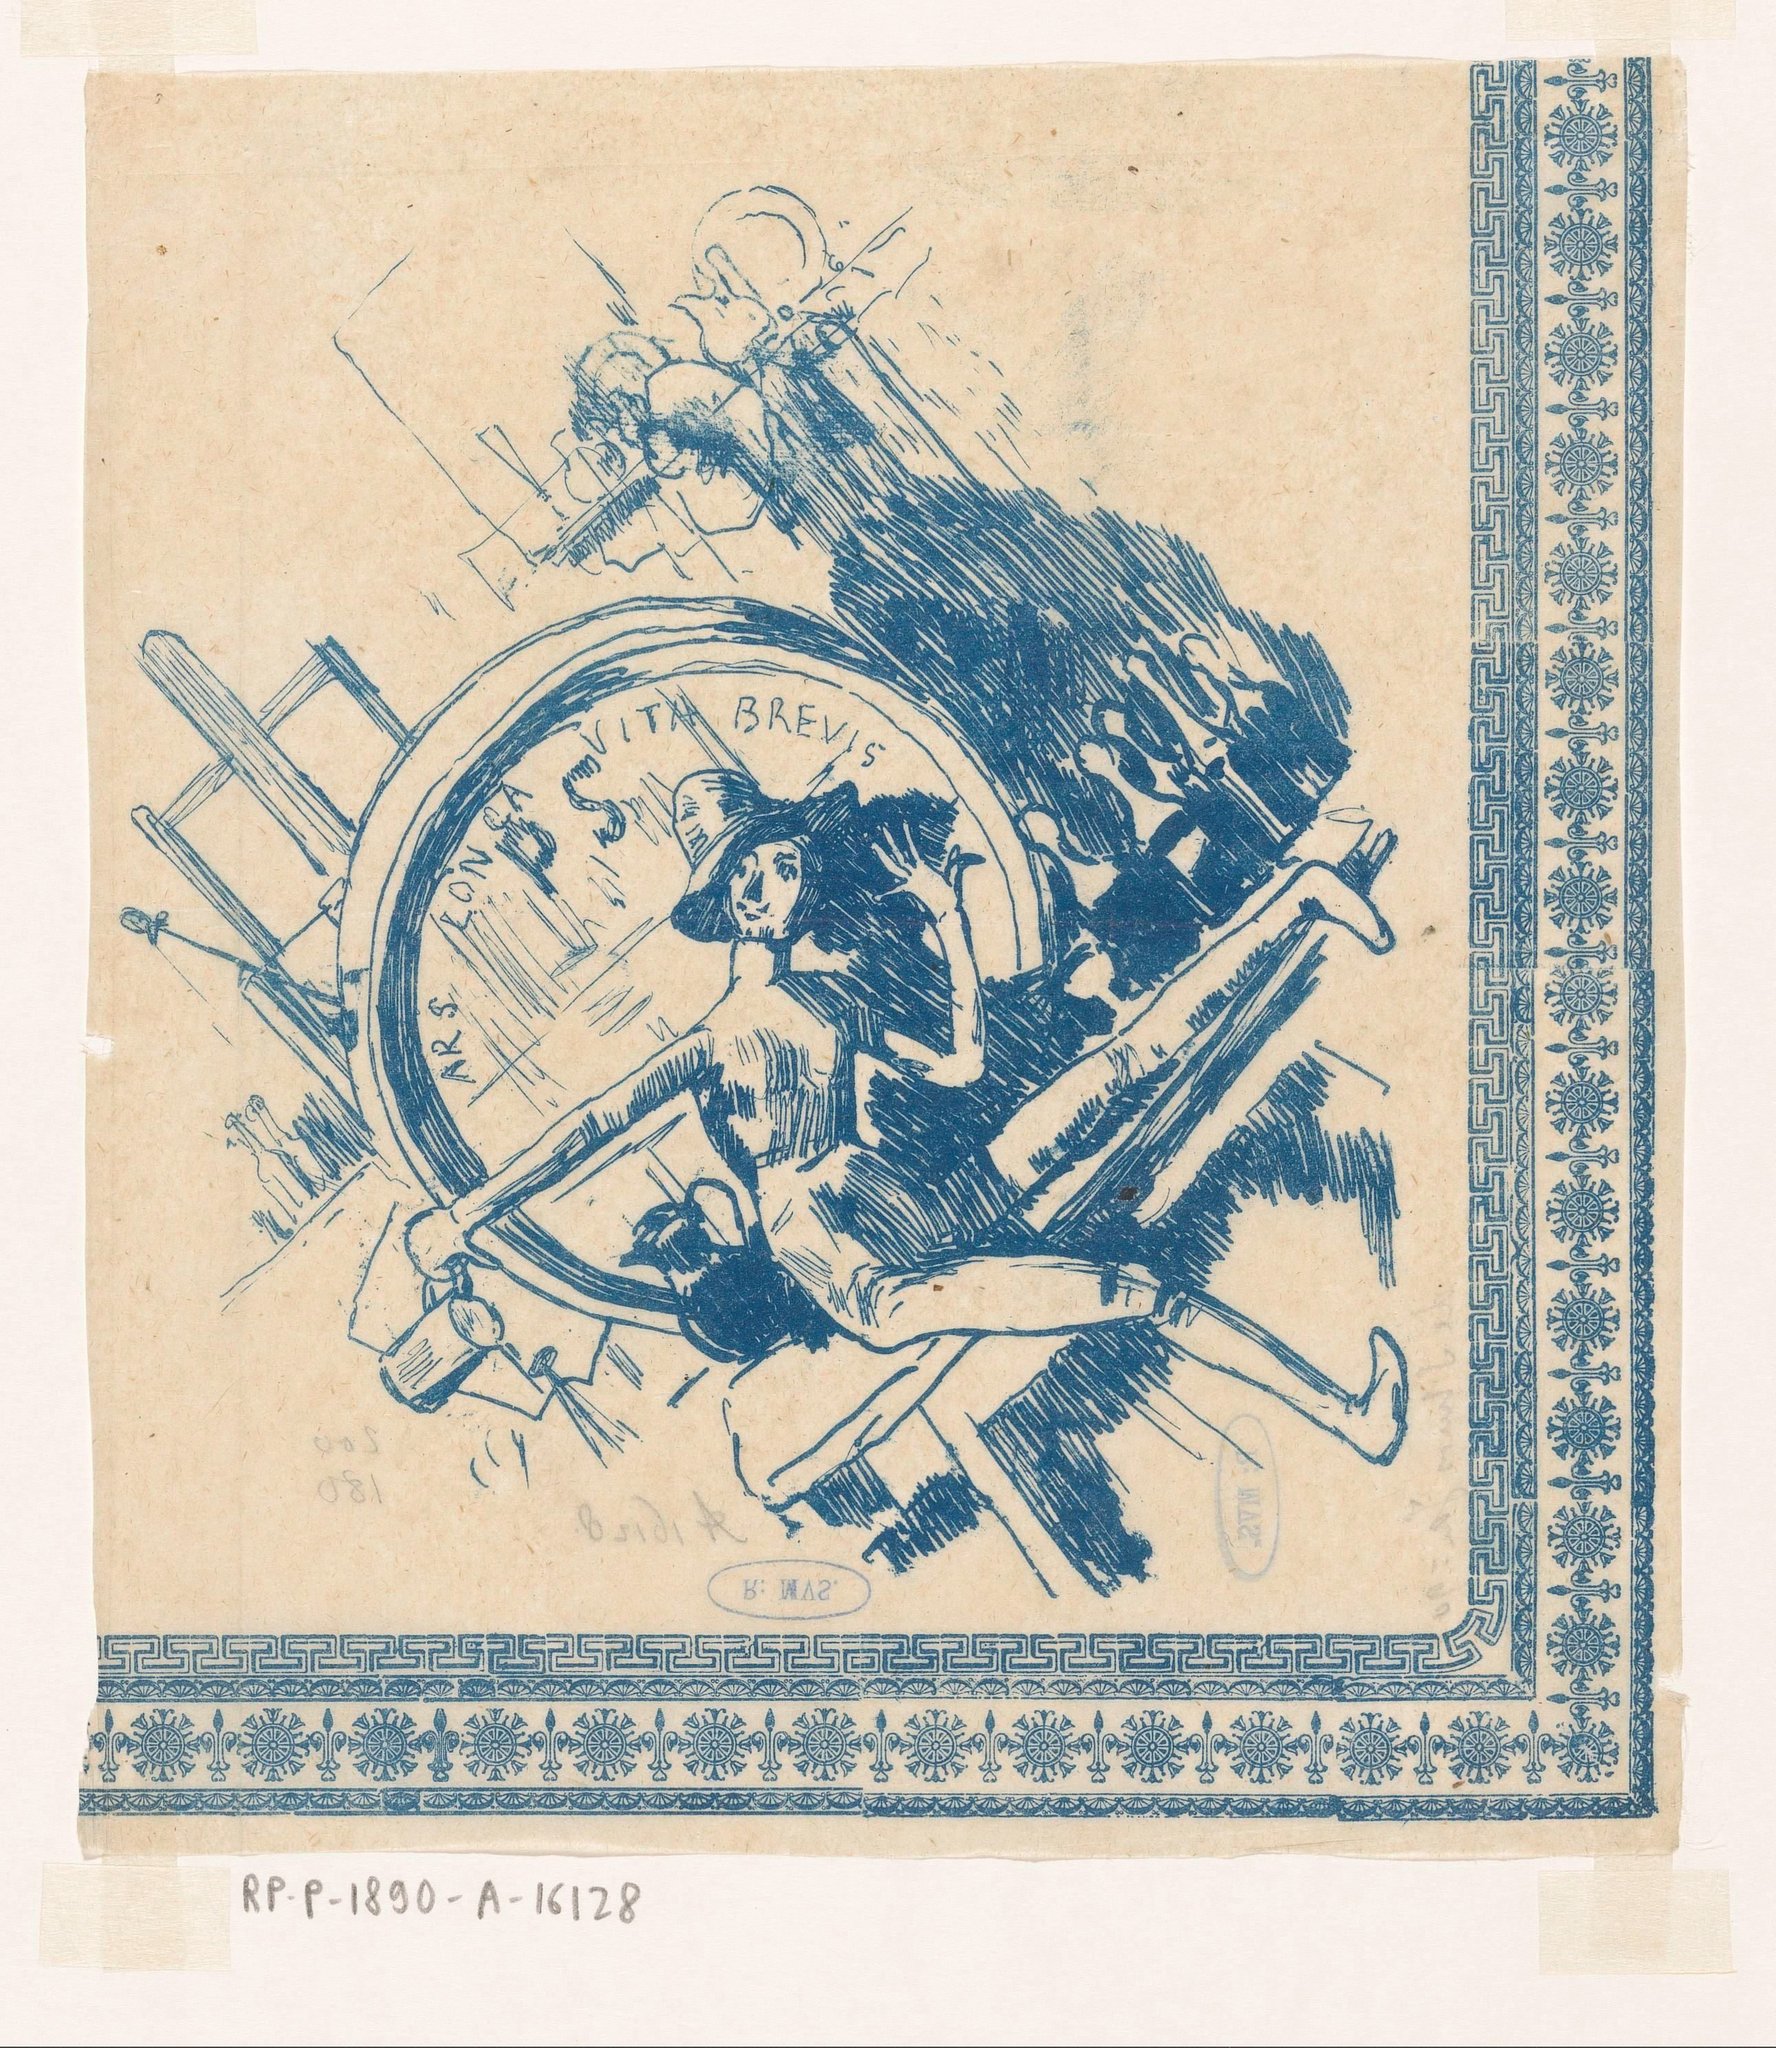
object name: print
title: Ars longa, vita brevis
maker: pieter de josselin de jong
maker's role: draughtsman, painter, print maker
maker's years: 1861-1906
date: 1871-1890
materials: paper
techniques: etching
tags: (playing with) dolls, beer, ale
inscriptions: collector's mark: Lugt 2228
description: Een op een bank geplaatste ledenpop houdt in zijn rechterhand een bierglas vast. Achter de pop een vat met daarop de tekst: 'Ars longa, vita brevis'.